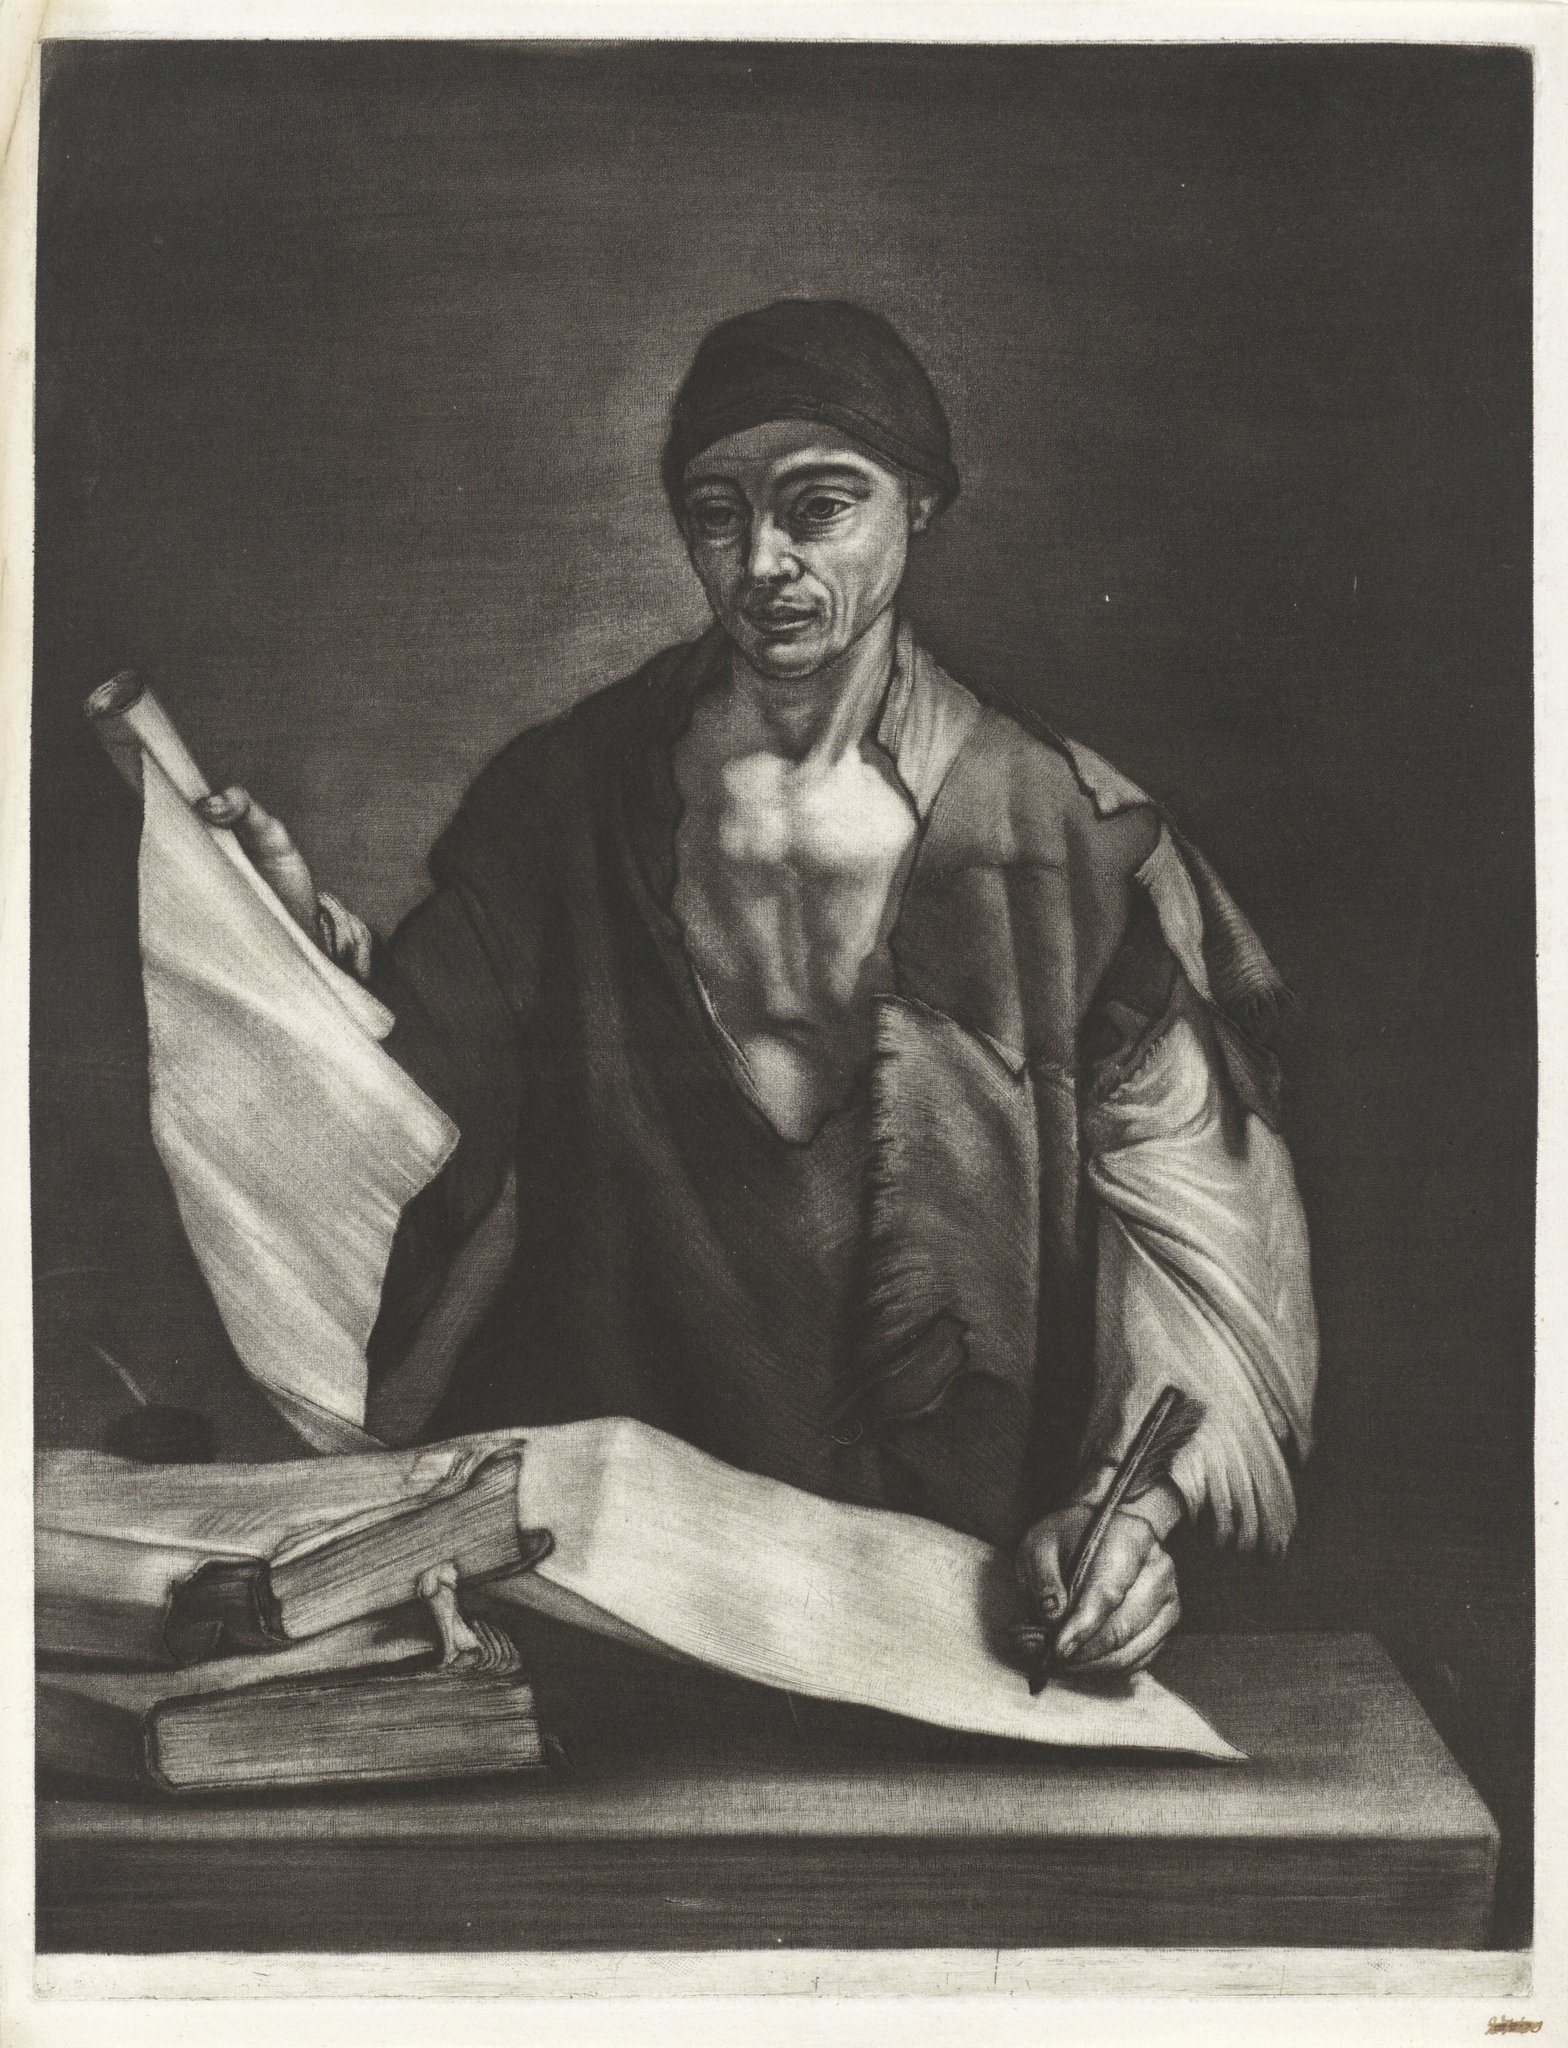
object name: print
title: Aristoteles schrijvend achter een bureau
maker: bernard vaillant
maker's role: draughtsman, painter, print maker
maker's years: 1632-1698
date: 1672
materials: paper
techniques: mezzotint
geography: amsterdam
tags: handwriting, writing as activity, scholar, philosopher, head-gear: cap (+ men's clothes)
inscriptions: collector's mark: Lugt 2760, collector's mark: Lugt 2228